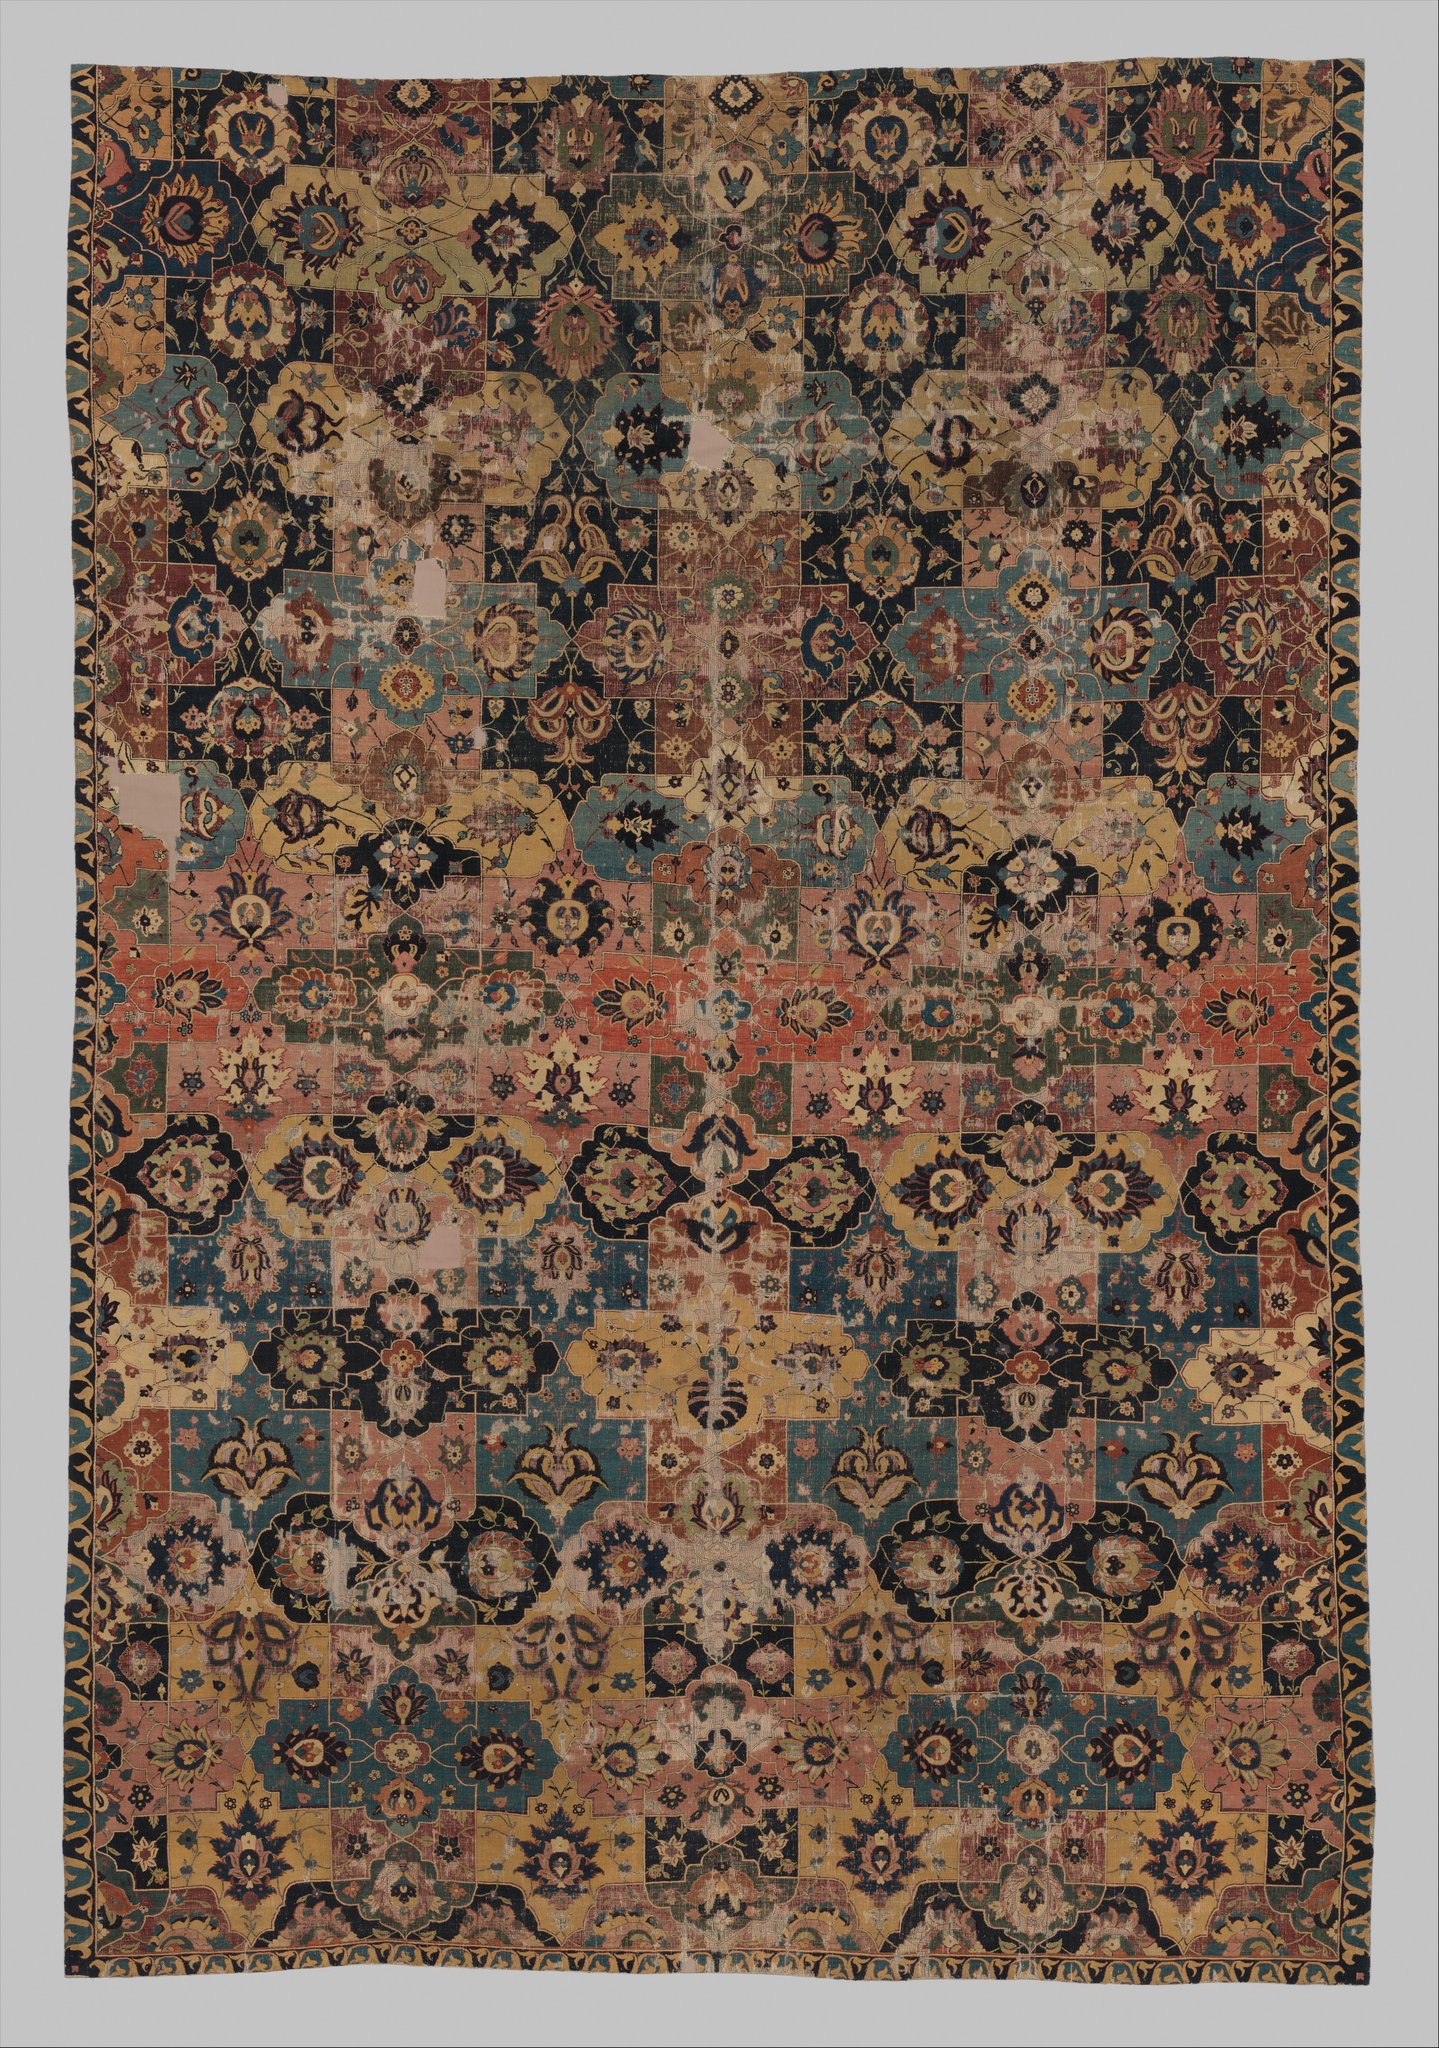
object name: carpet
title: Vase-technique Carpet with Overlapping Cartouches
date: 1601-1700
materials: cotton, silk, wool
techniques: asymmetrically knotted pile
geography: iran